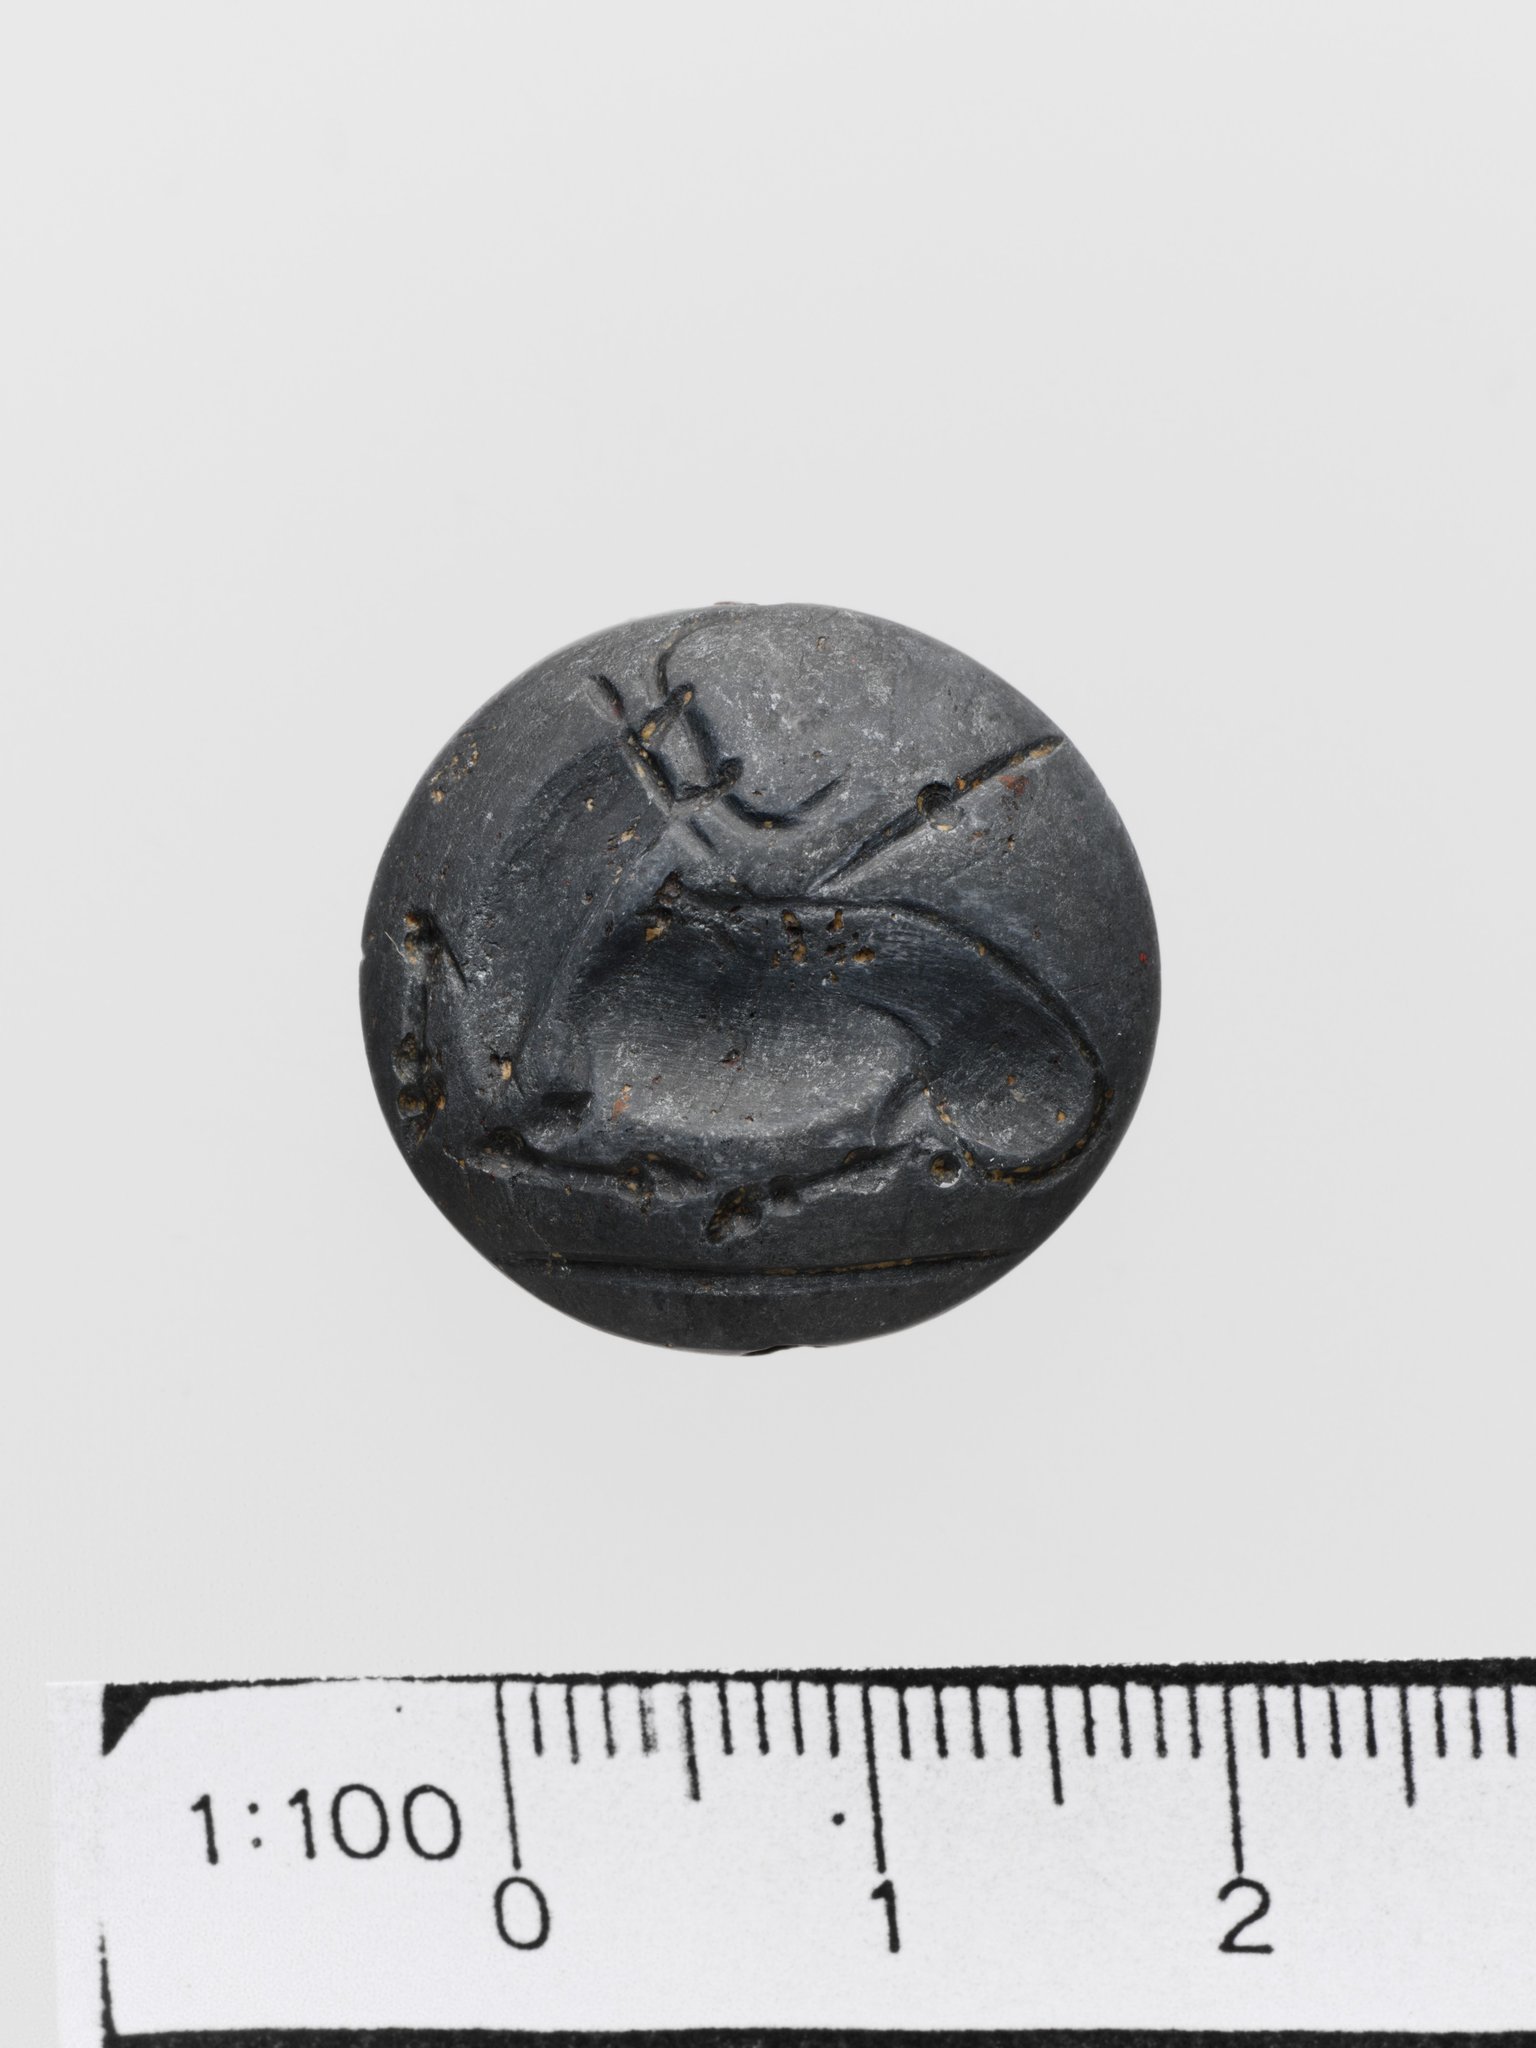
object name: seal, lentoid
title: Haematite lentoid seal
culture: minoan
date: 1450-1400 BCE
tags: bulls